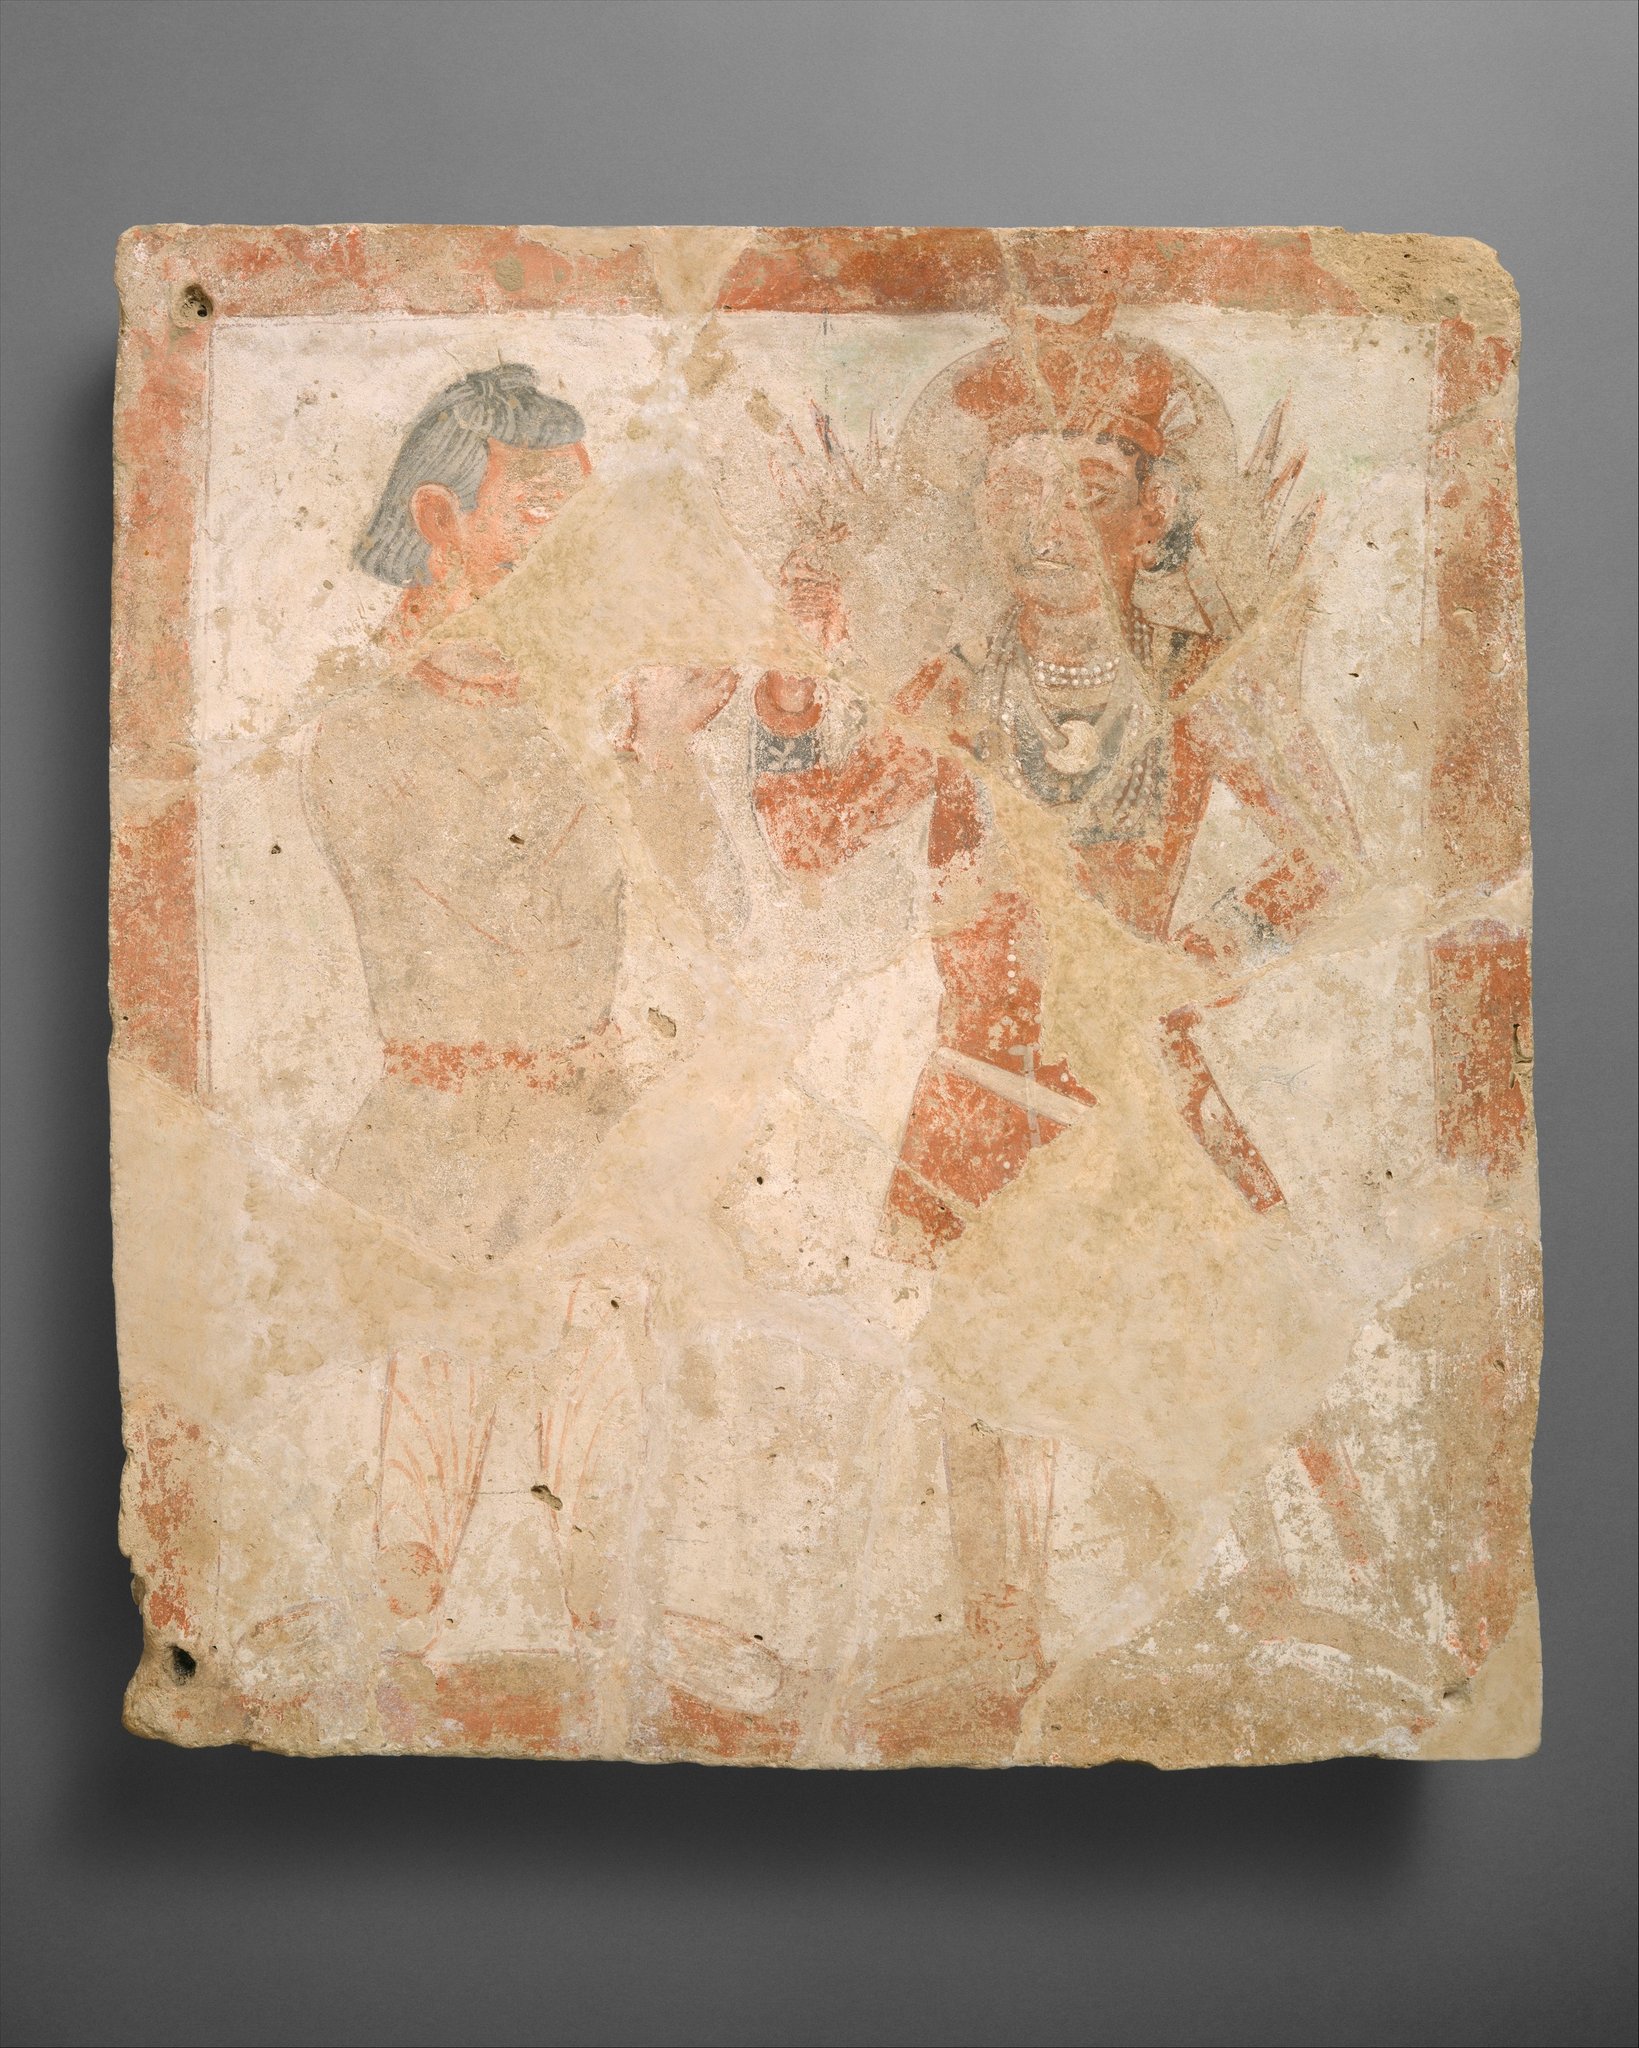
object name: painted panel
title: Panel with the god Pharro and worshiper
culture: kushan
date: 201-300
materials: gouache, terracotta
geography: bactria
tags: men,gods